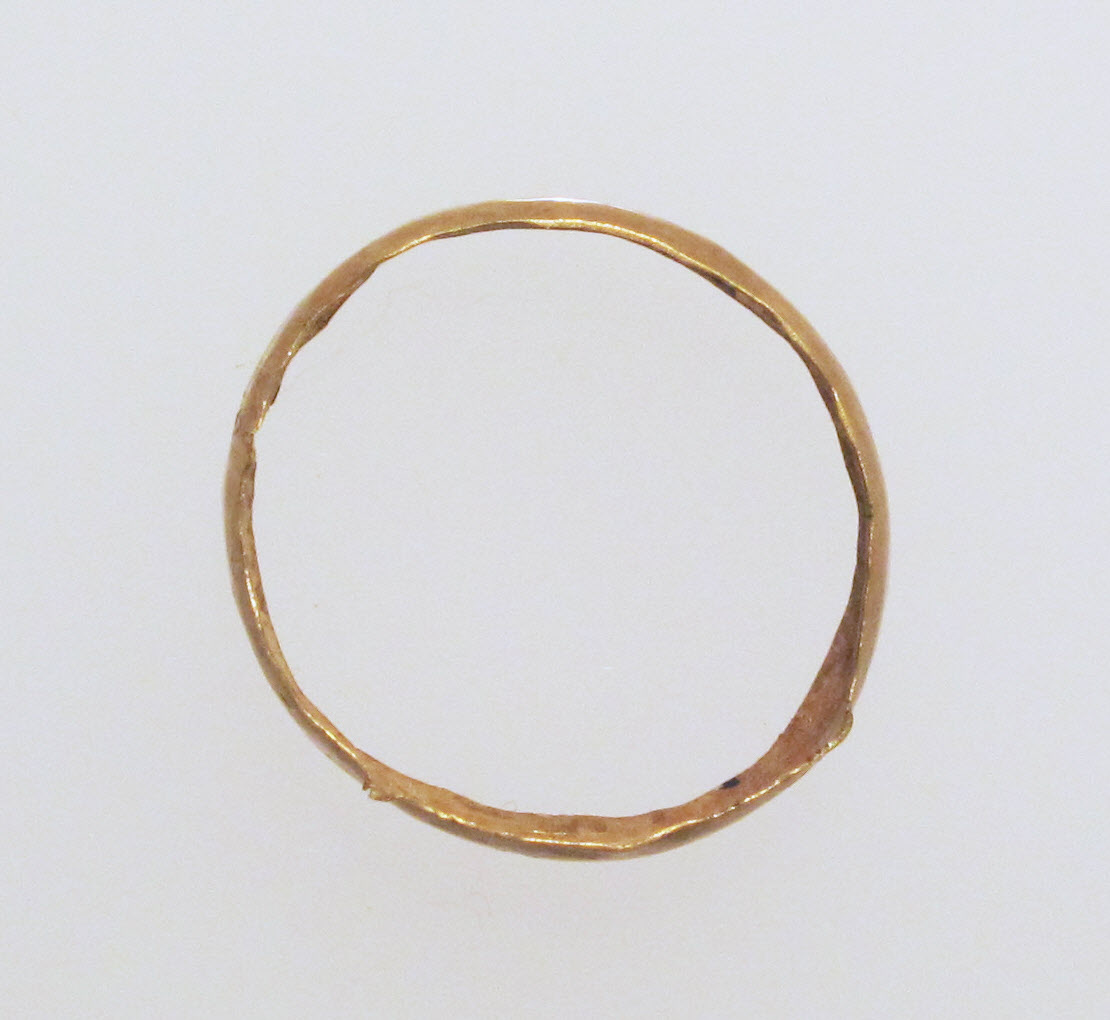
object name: ring with hollow hoop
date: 7000 BCE-330 CE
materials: gold